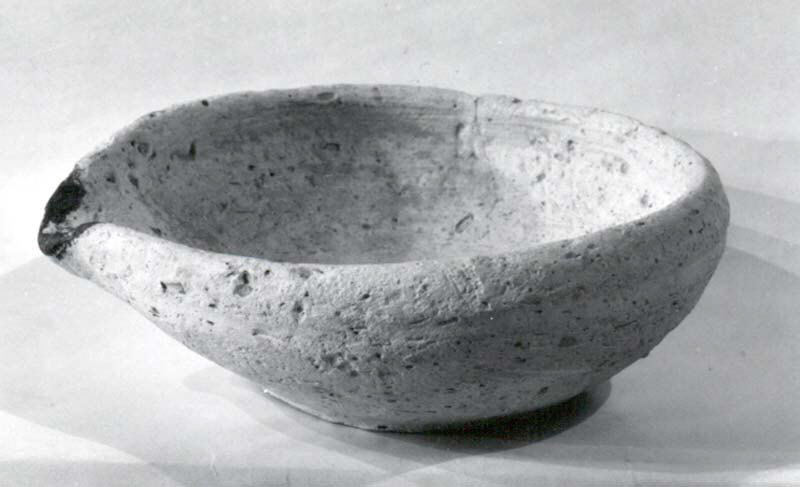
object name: lamp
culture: sasanian or islamic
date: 501-800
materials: ceramic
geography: iran